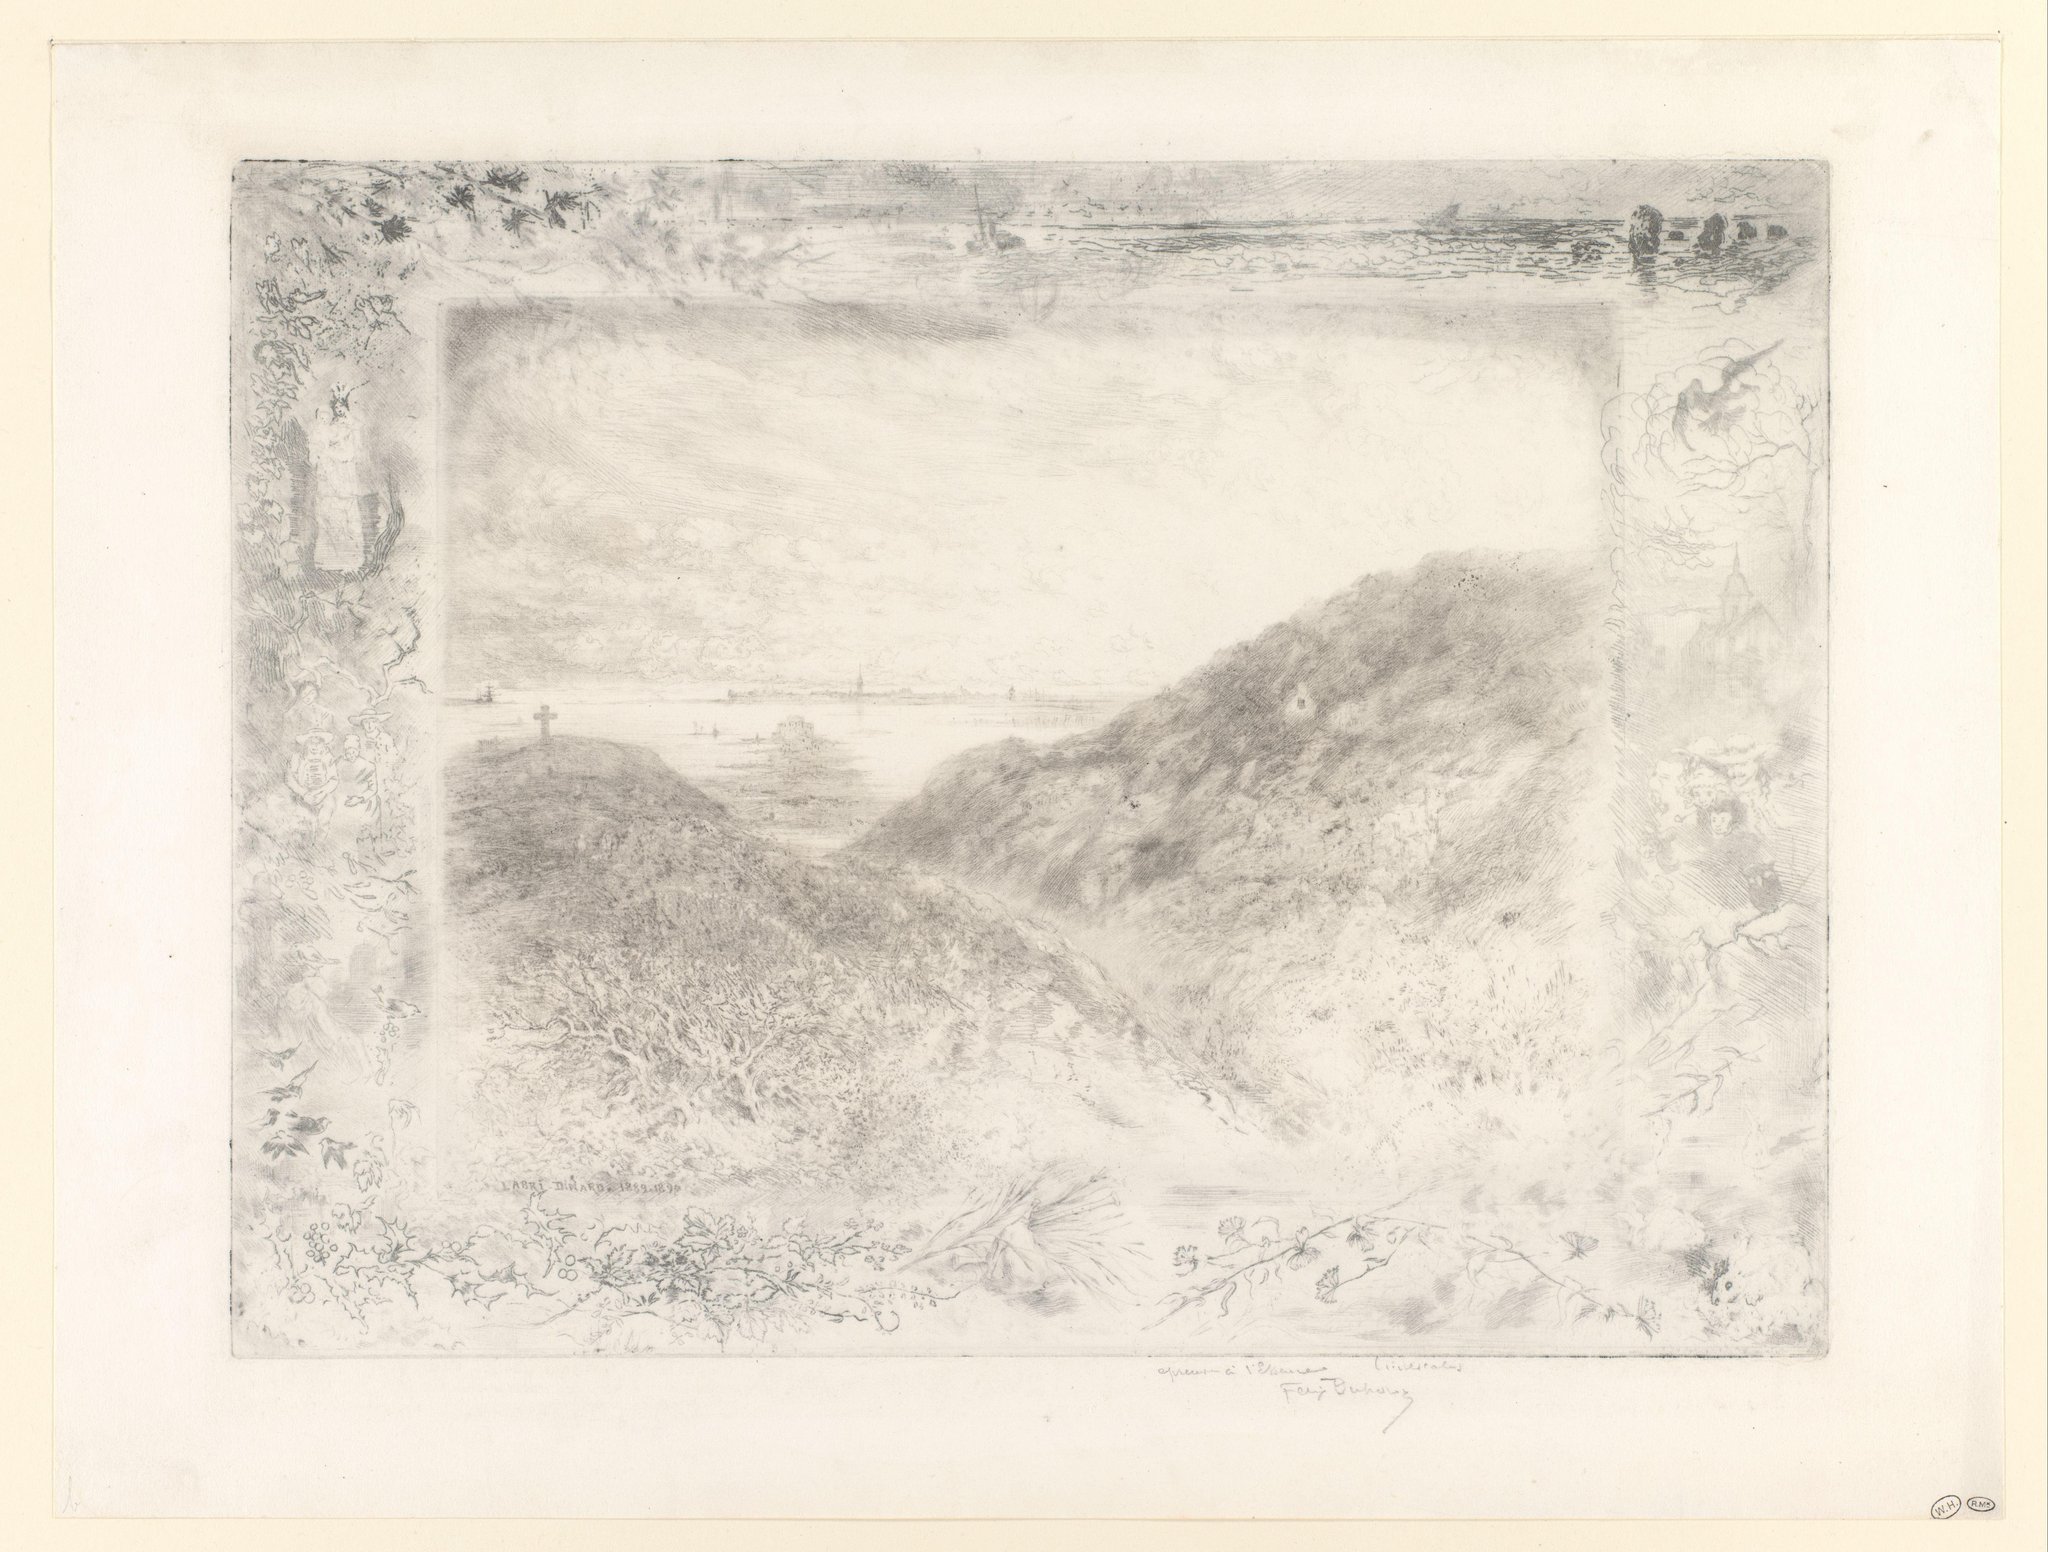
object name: print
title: Duinlandschap met een gezicht op La Falaise, Baie de St. Malo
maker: félix hilaire buhot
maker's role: draughtsman, print maker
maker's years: 1847-1898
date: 1889-1890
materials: paper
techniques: aquatint, etching, roulette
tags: gulf, bay, dune coast, cross as symbol of christ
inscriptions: collector's mark: Lugt 2760, collector's mark: Lugt 2625, collector's mark: Lugt 2229, collector's mark: Lugt 2228, signature: ‘epreuve à l'Esse[...] Felix Buhot’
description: Karakteristiek voor Buhot zijn de illustraties die hij in de marges van zijn prenten plaatste, zoals ook bij deze prent het geval is. De inventie die hij "marges symphoniques" noemde, versterkte het hoofdonderwerp van de prent en maakte er integraal deel van uit. Buhot werd geïnspireerd door decoraties in de marges van Middeleeuwse manuscripten en achttiende-eeuwse Franse boekillustraties.